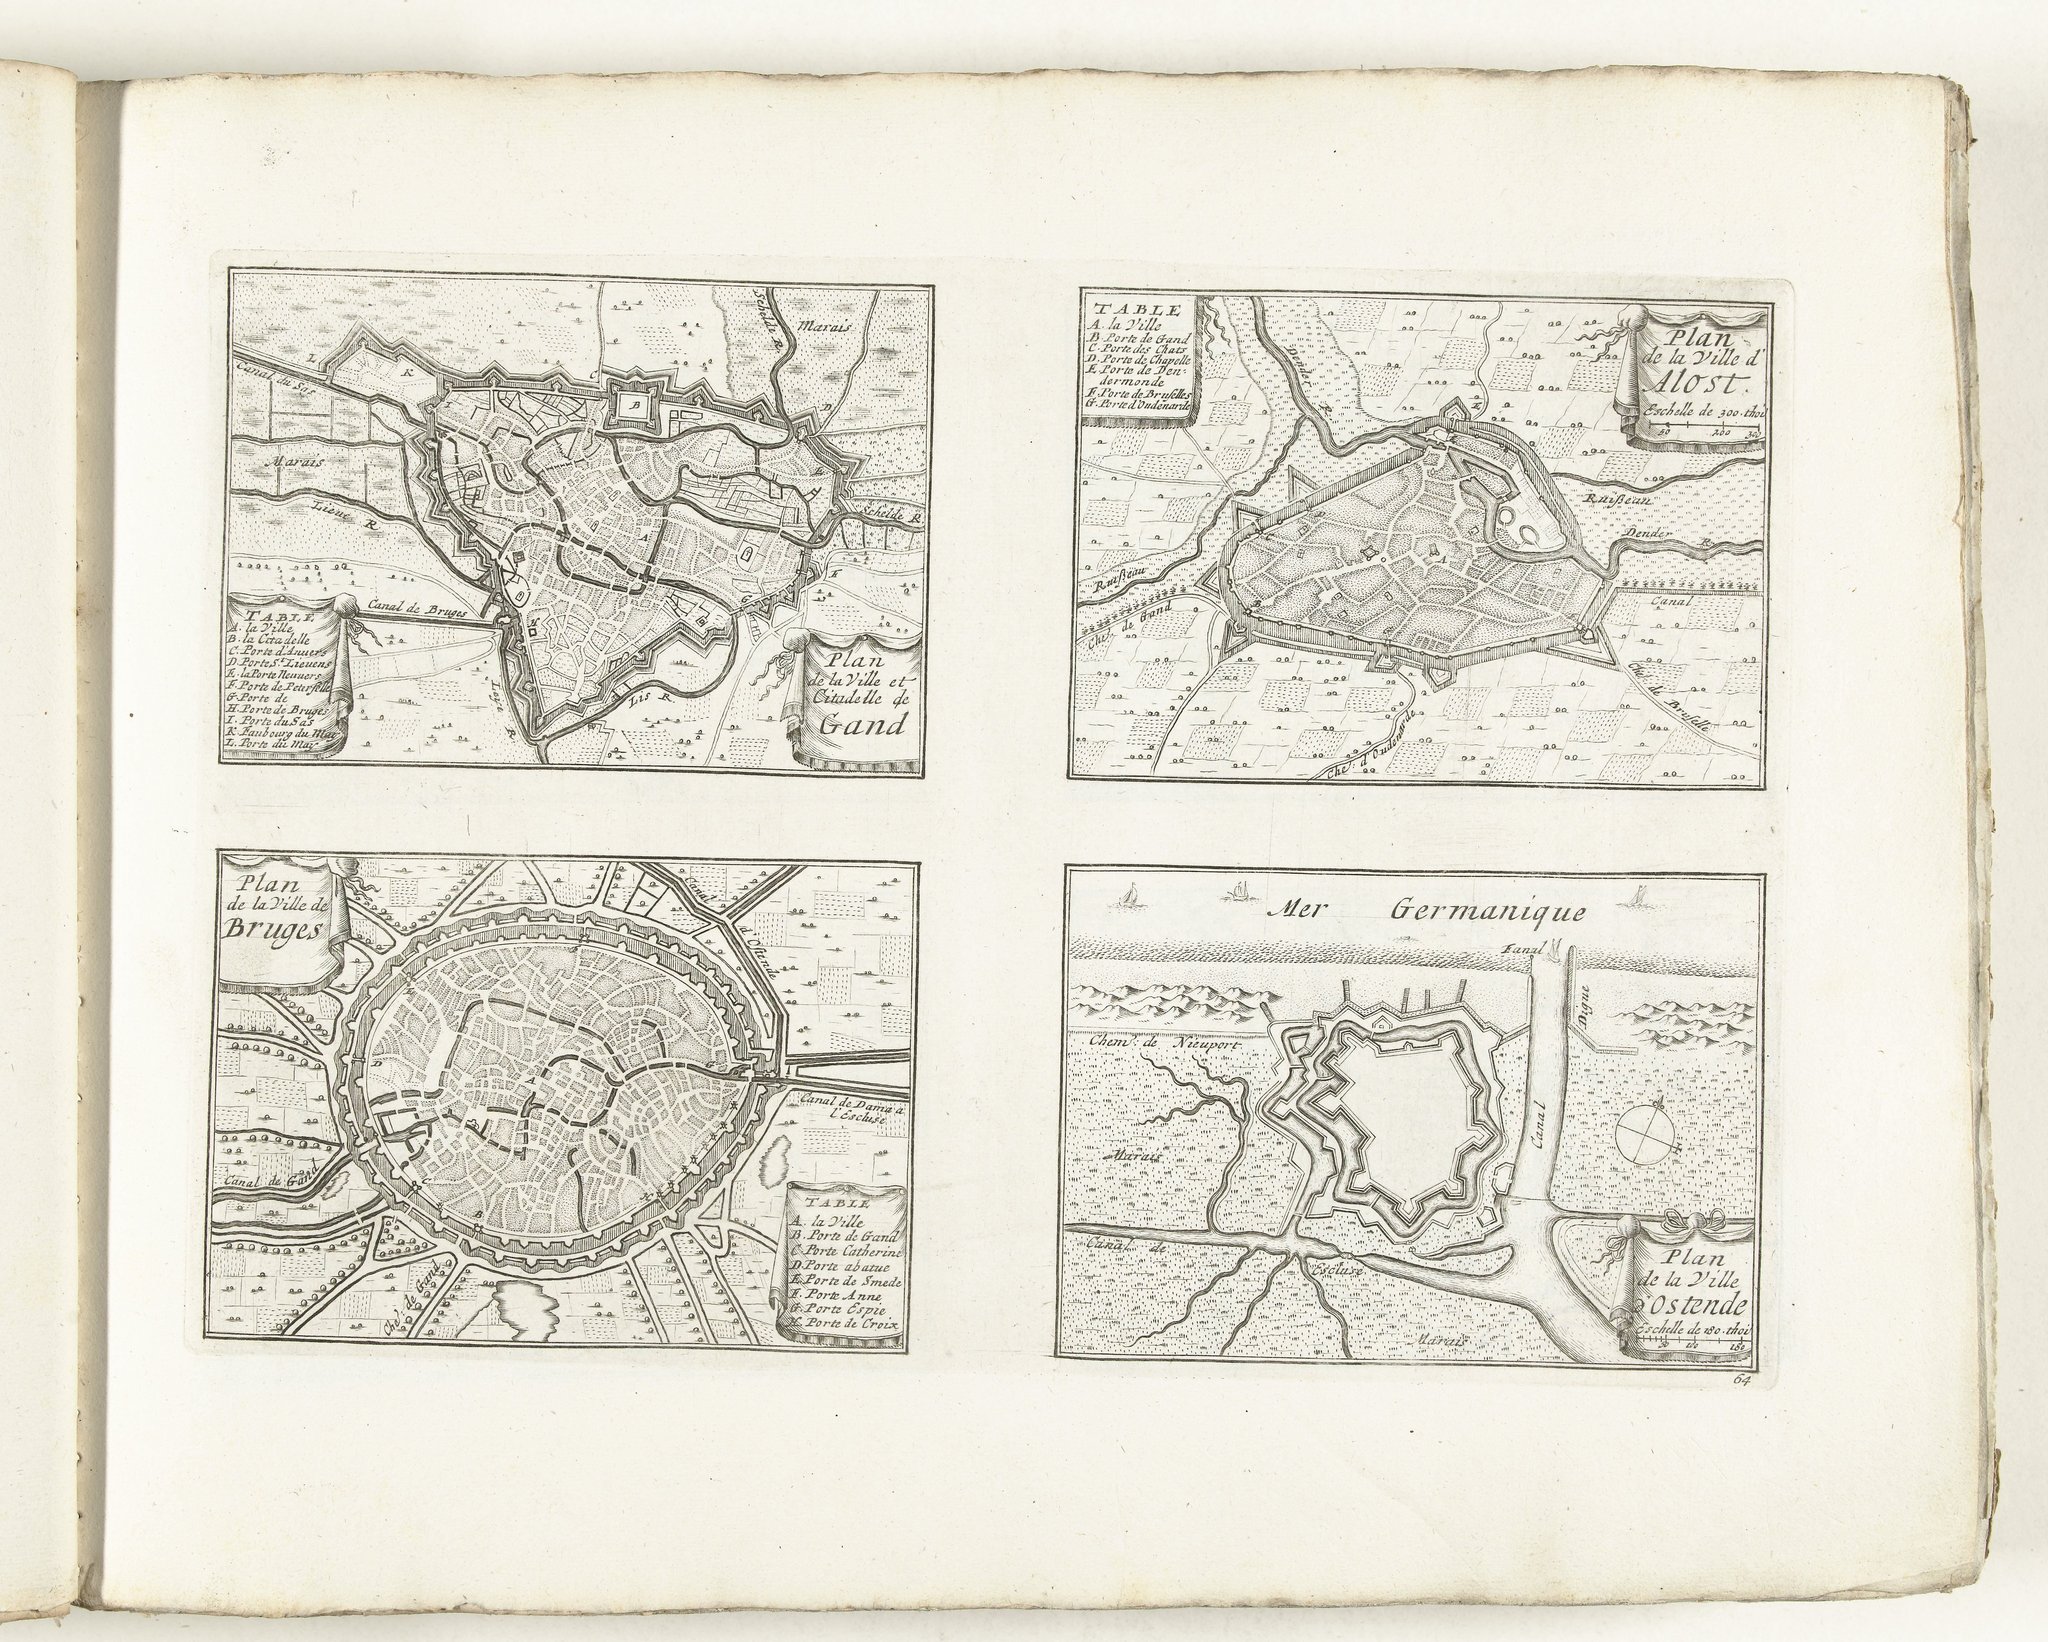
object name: map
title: Gand / Alost / Bruges / Ostende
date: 1702-1703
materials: paper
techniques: engraving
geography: northern netherlands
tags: fortress, maps of cities, ghent, bruges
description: Blad met vier plattegronden van de verdedigingswerken om de Vlaamse steden Gent, Aalst, Brugge en Oostende. Plaat nr. 64 in het prentwerk bestaande in totaal uit 276 genummerde platen van vermaarde sterke steden en vestingen in het kader van de Spaanse Successieoorlog. Voor het merendeel zijn deze platen gekopieerd naar de anonieme Franse platen: in Les forces de l'Europe en in: Le theatre de la guerre, dans les Pays-Bas, beide oorspronkelijk uitgegeven door Nicolas de Fer te Parijs (1693-1697) in het kader van de Negenjarige Oorlog. Titel en opschriften in de plaat in het Frans.